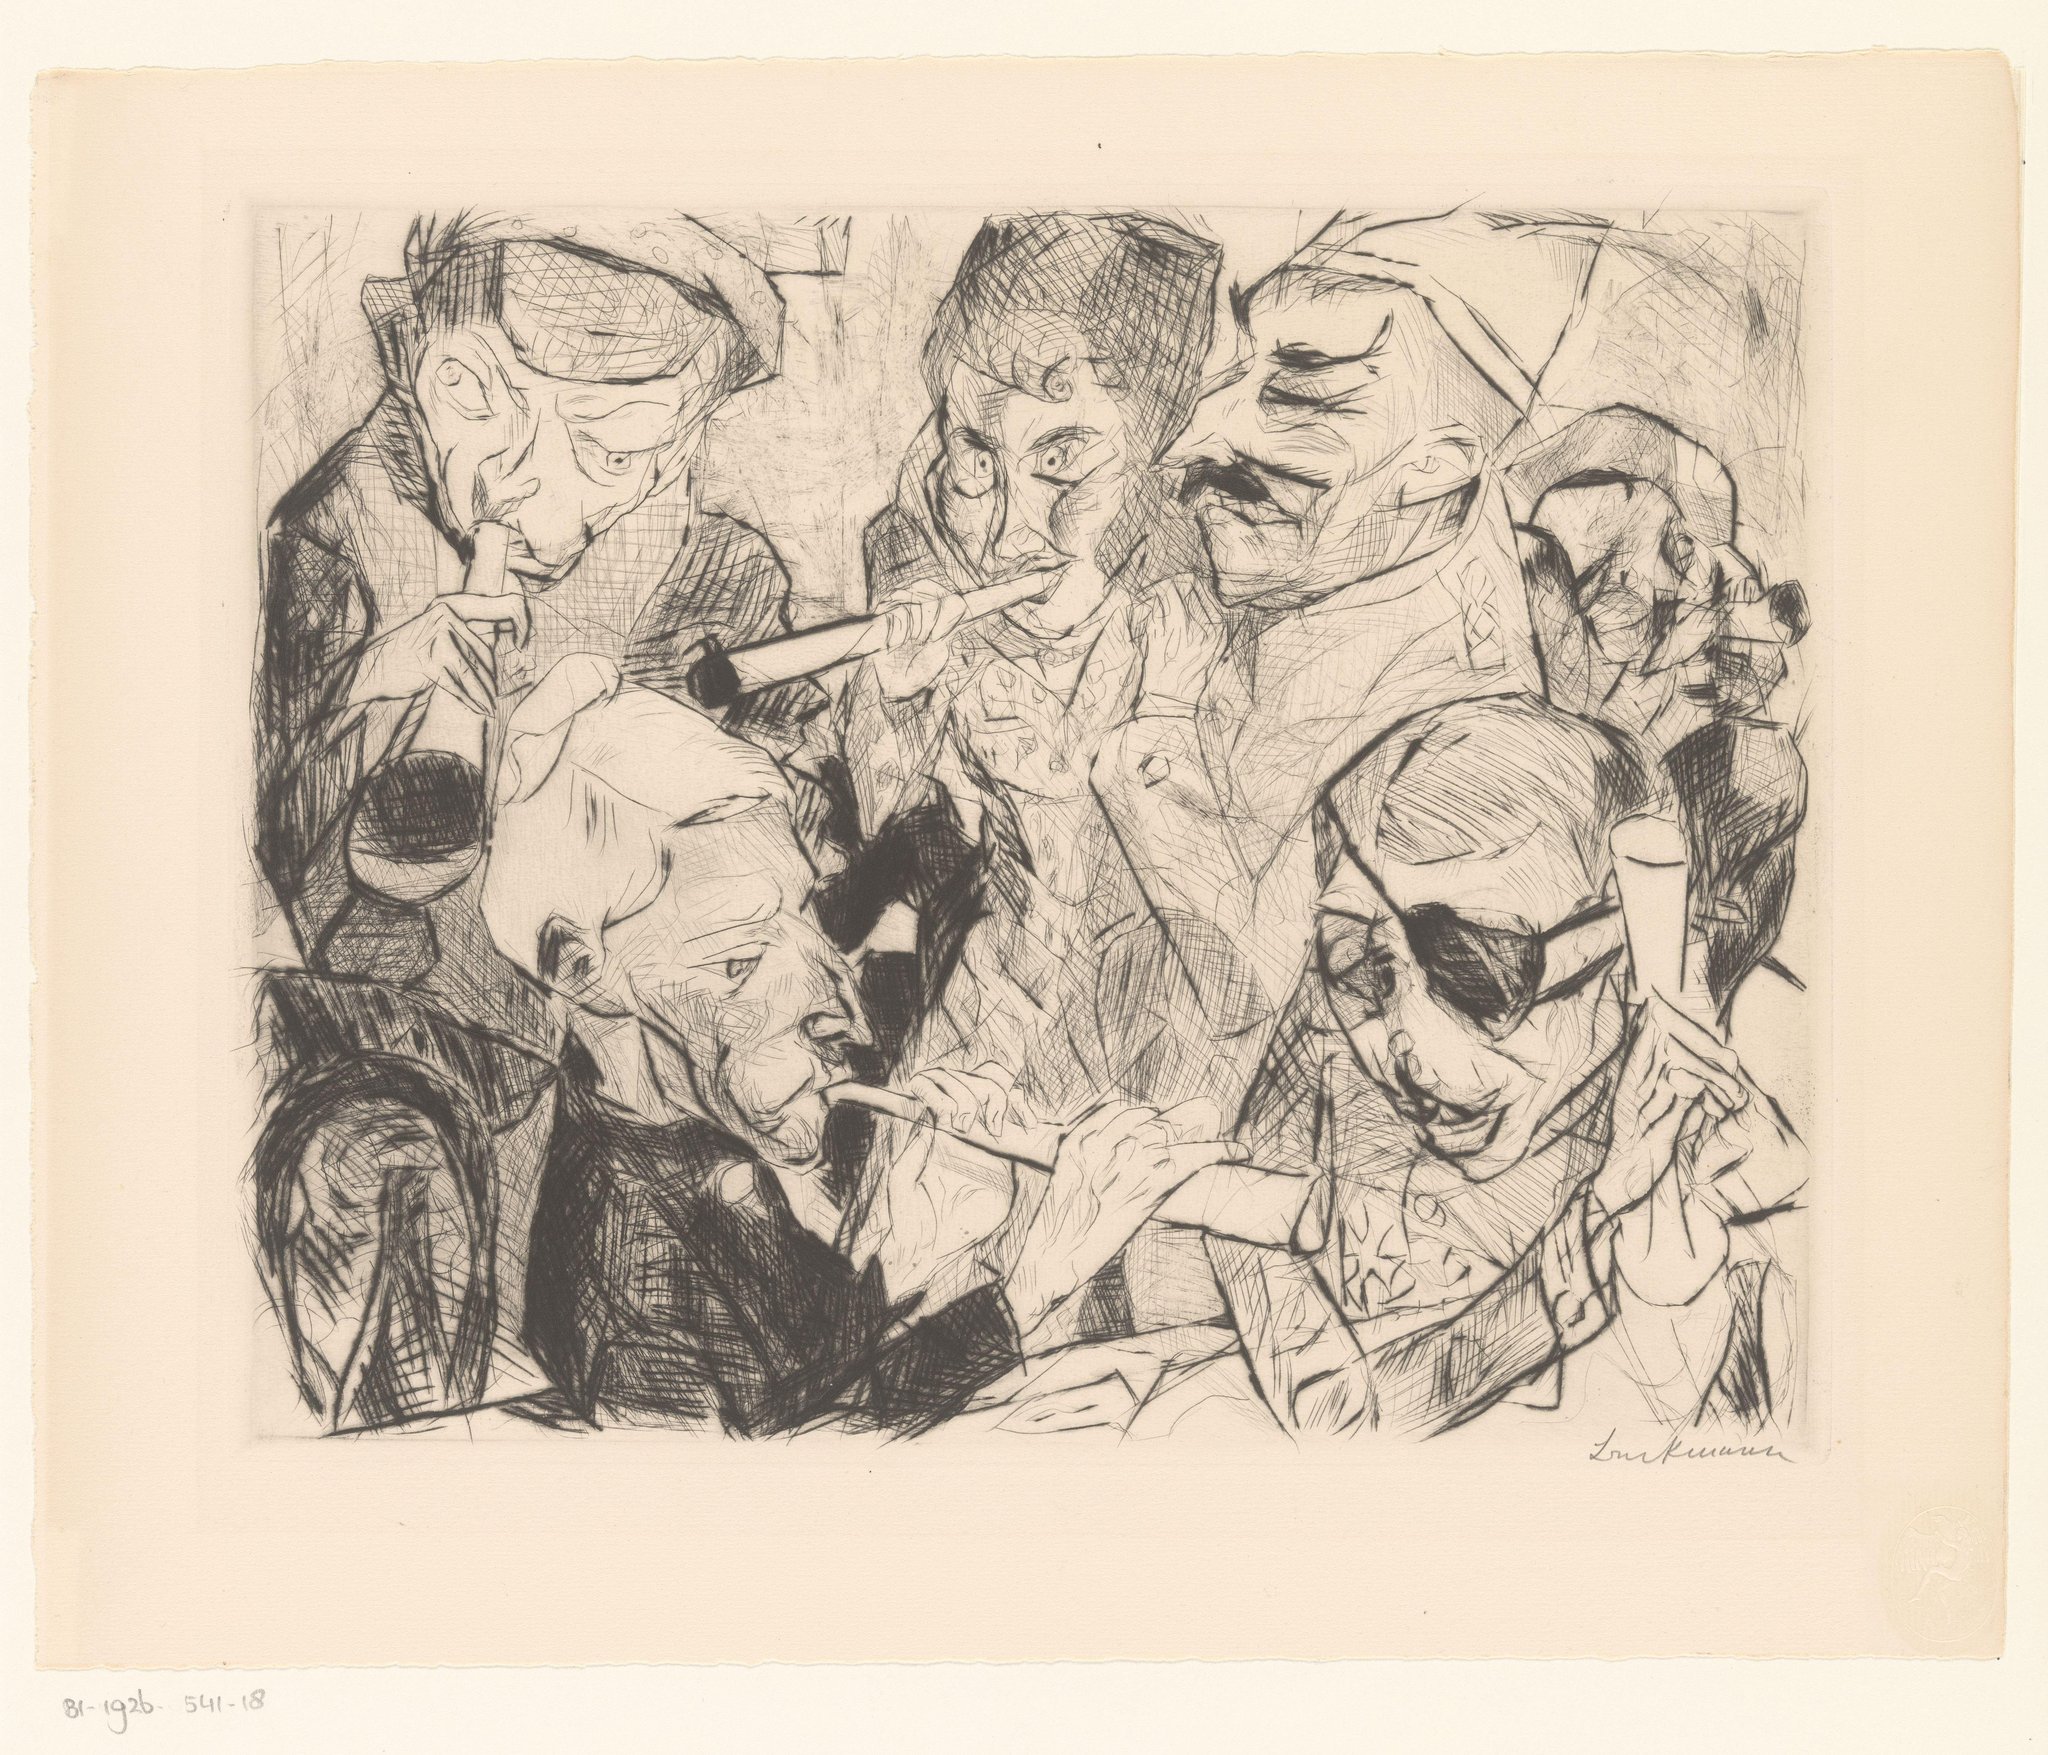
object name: print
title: Groep mensen proost op de jaarwisseling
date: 1917-1919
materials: paper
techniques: drypoint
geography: munich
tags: new year's eve (december 31)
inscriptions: collector's mark: Lugt 5629, collector's mark: Lugt 2166